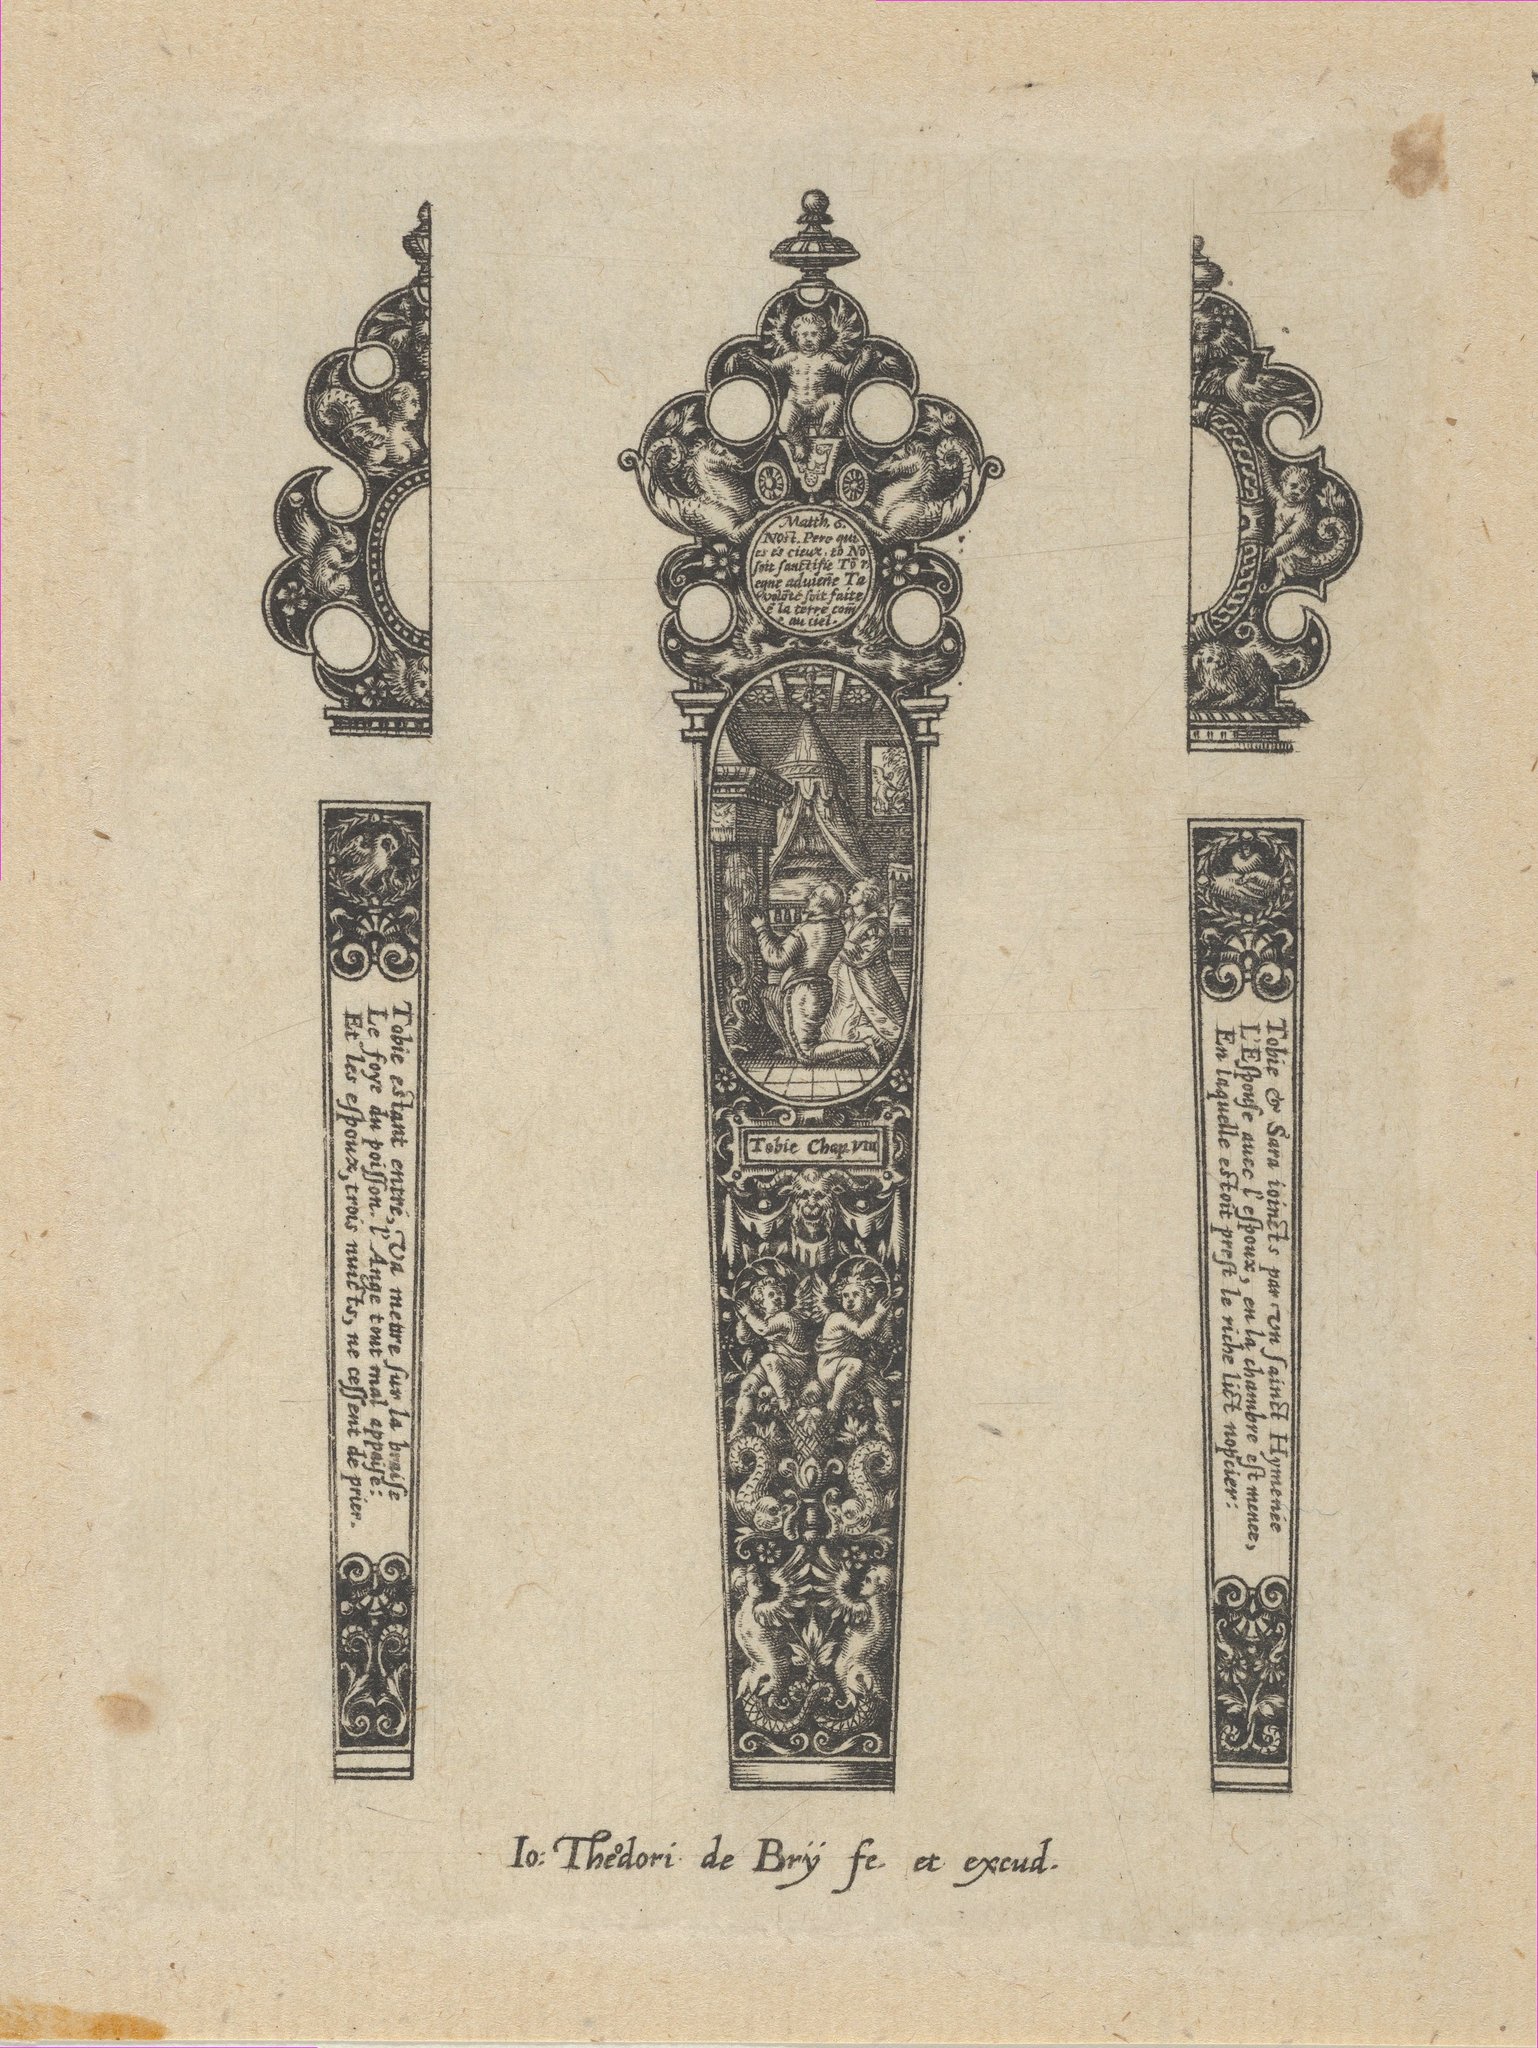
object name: print ornament architecture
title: Design for a Knife Handle with a Scene from the Book of Tobit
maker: johann theodor de bry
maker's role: artist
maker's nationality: netherlandish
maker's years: 1561-1623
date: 1580-1600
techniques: embroidery, engraving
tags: hilts